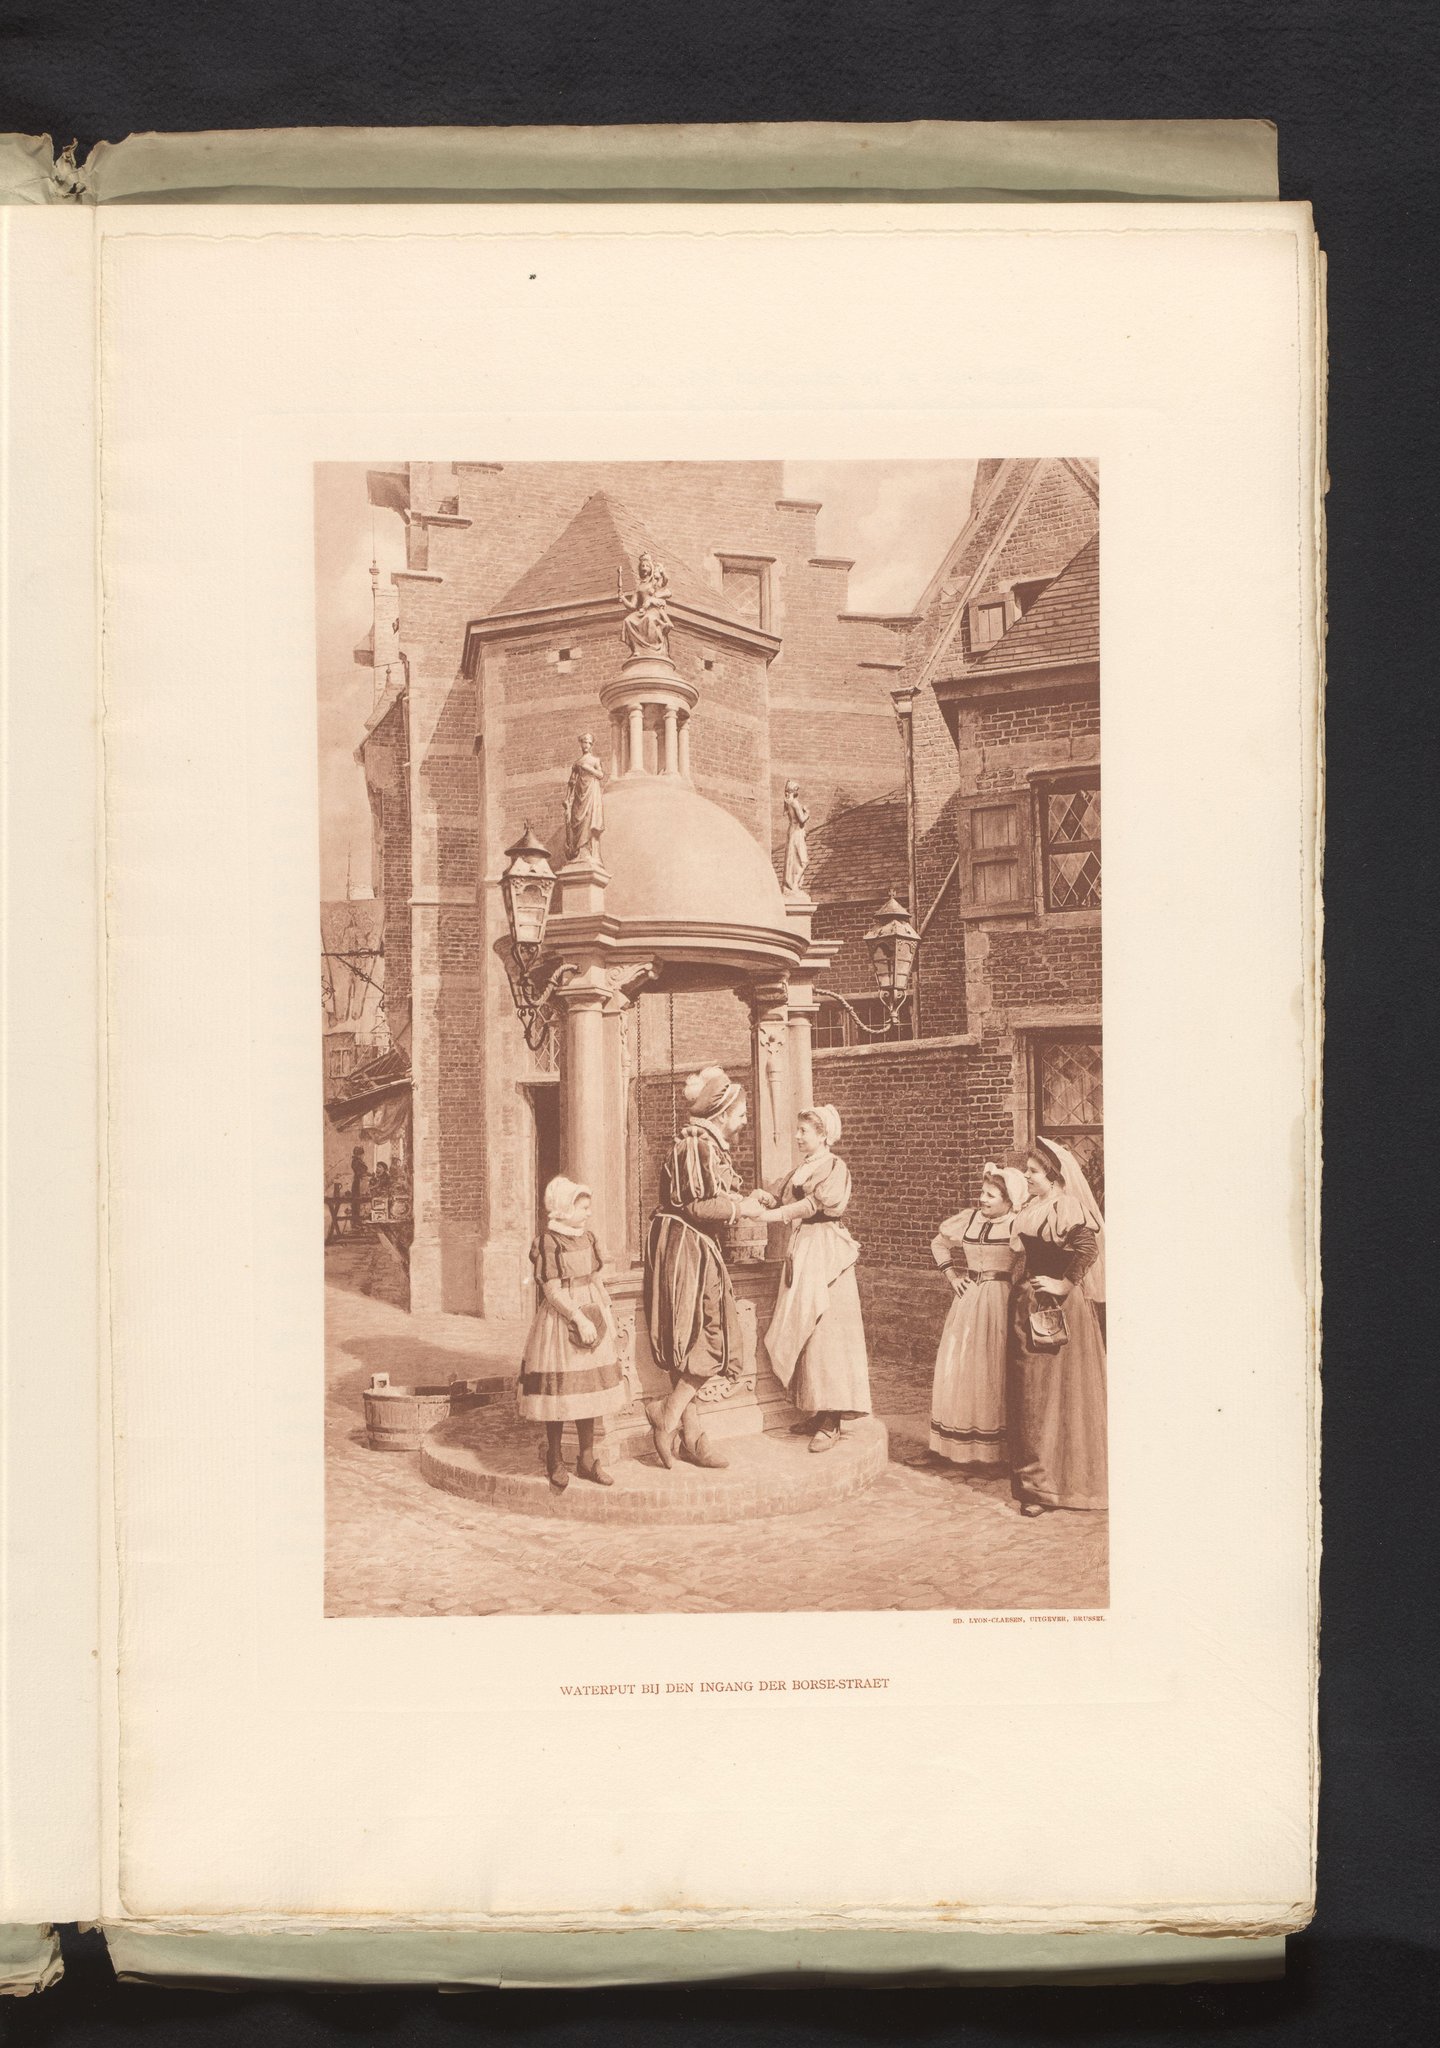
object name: page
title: Waterput bij den ingang van der Borse-straet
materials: paper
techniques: photograph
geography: antwerp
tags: well, world fair, world exhibition, antwerp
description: Prent op los blad tussen pagina 26 en 27.